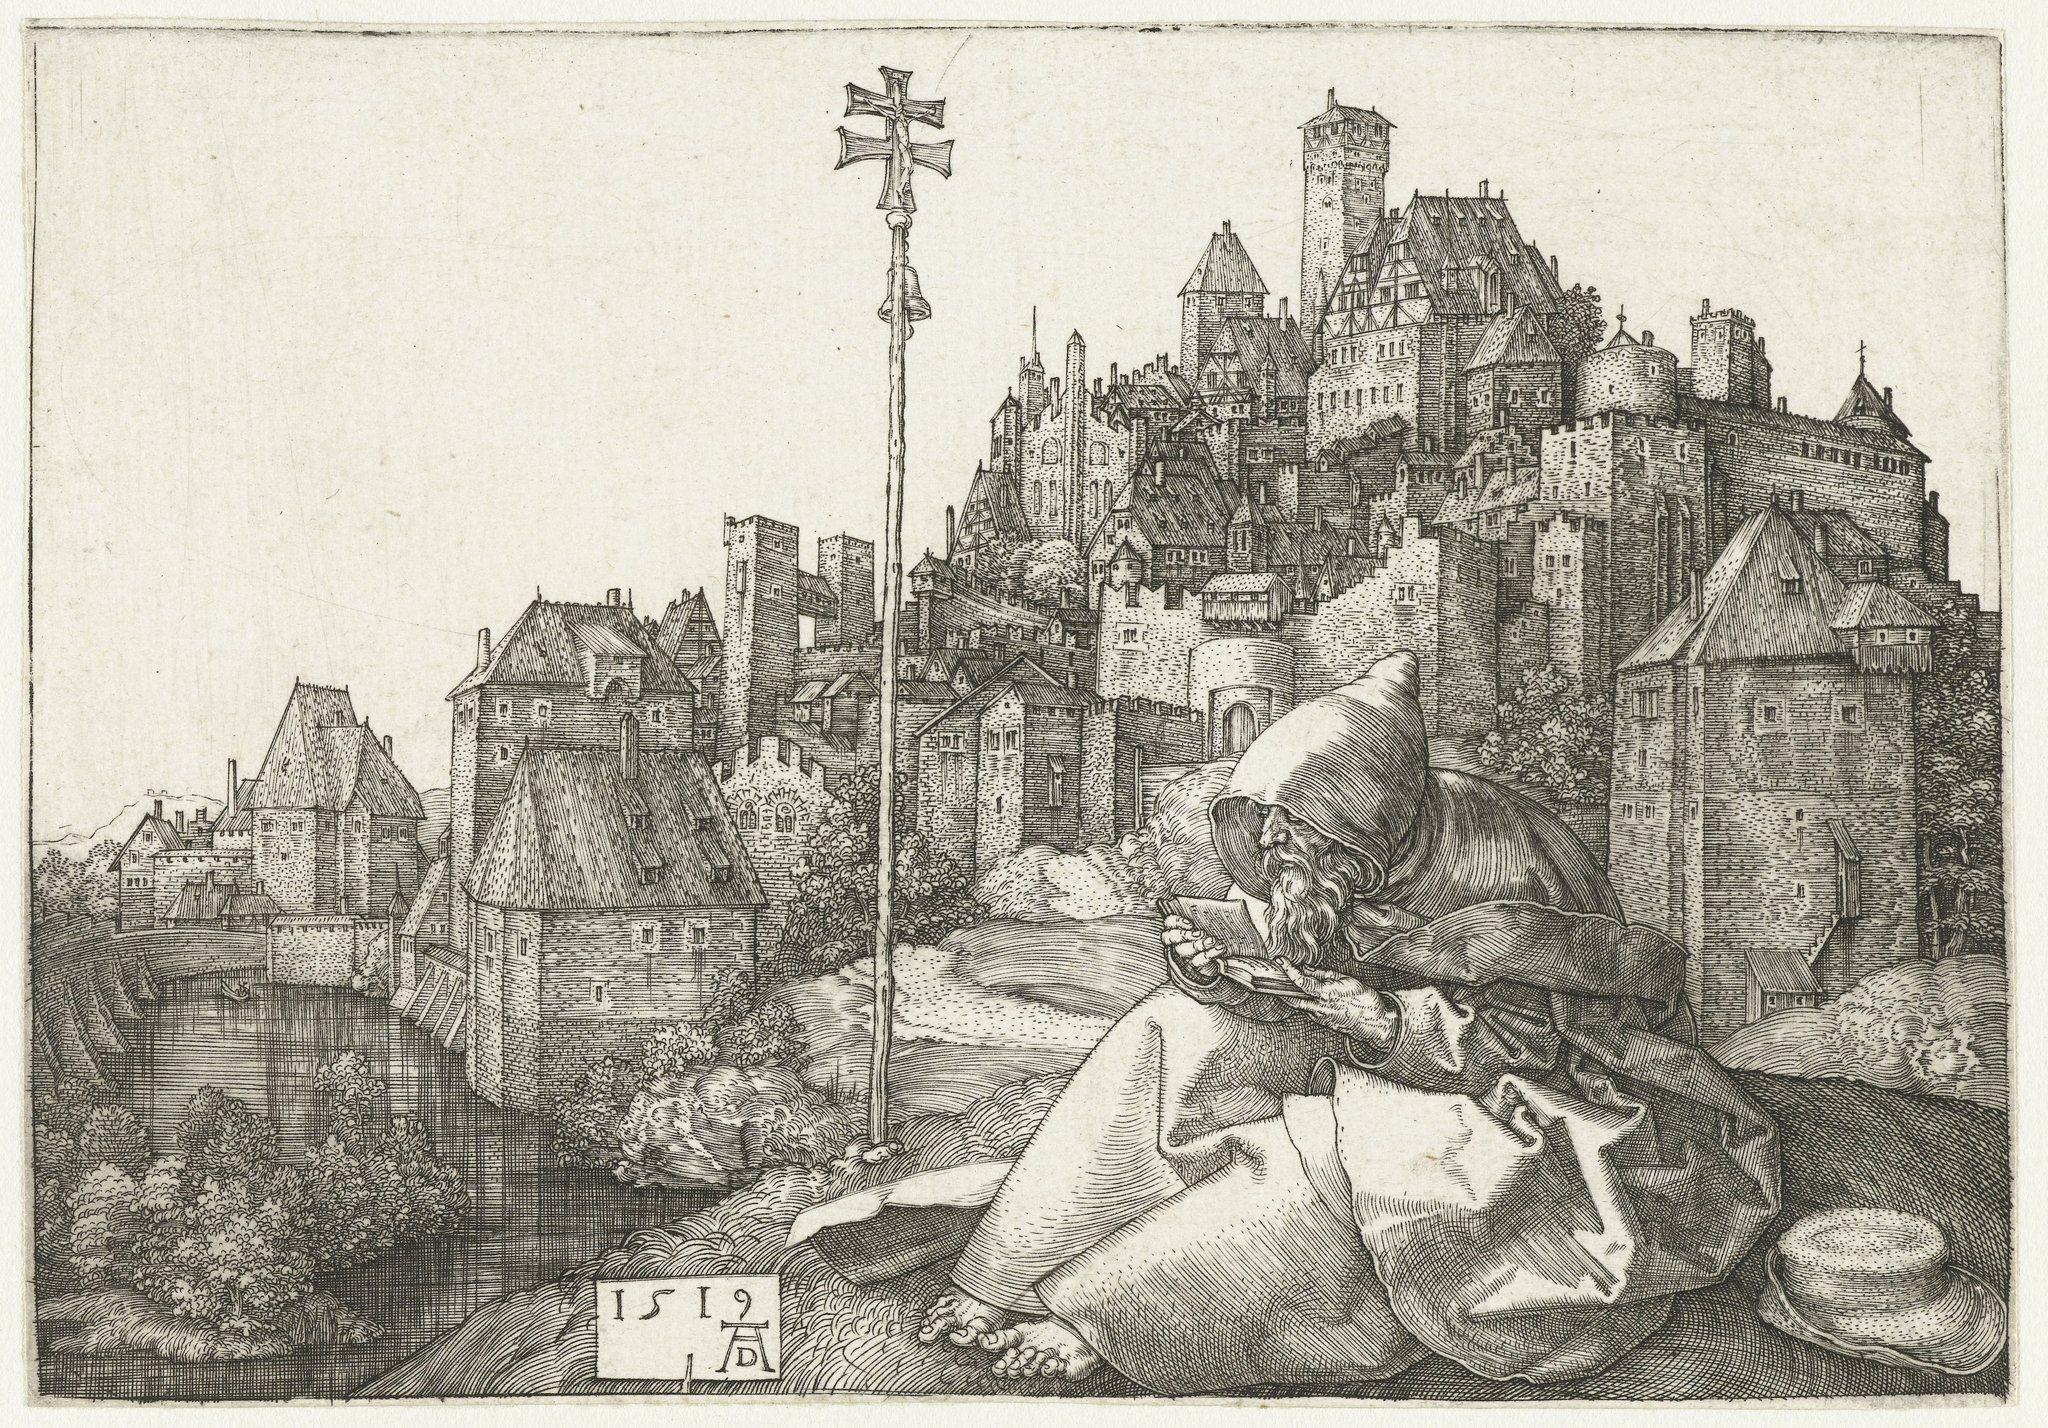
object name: print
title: De Heilige Antonius voor een stad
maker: albrecht dürer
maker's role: draughtsman, painter, print maker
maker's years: 1471-1528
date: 1519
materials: paper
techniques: engraving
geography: nuremberg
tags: the hermit antony abbot (antonius abbas) of egypt, also called the great; possible attributes: bell, book, t-shaped staff, flames, pig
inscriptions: collector's mark: Lugt 2228a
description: De Heilige Antonius zit op de grond te lezen, net buiten een stad. Naast hem staat een staf met een dubbelkruis en een klokje.